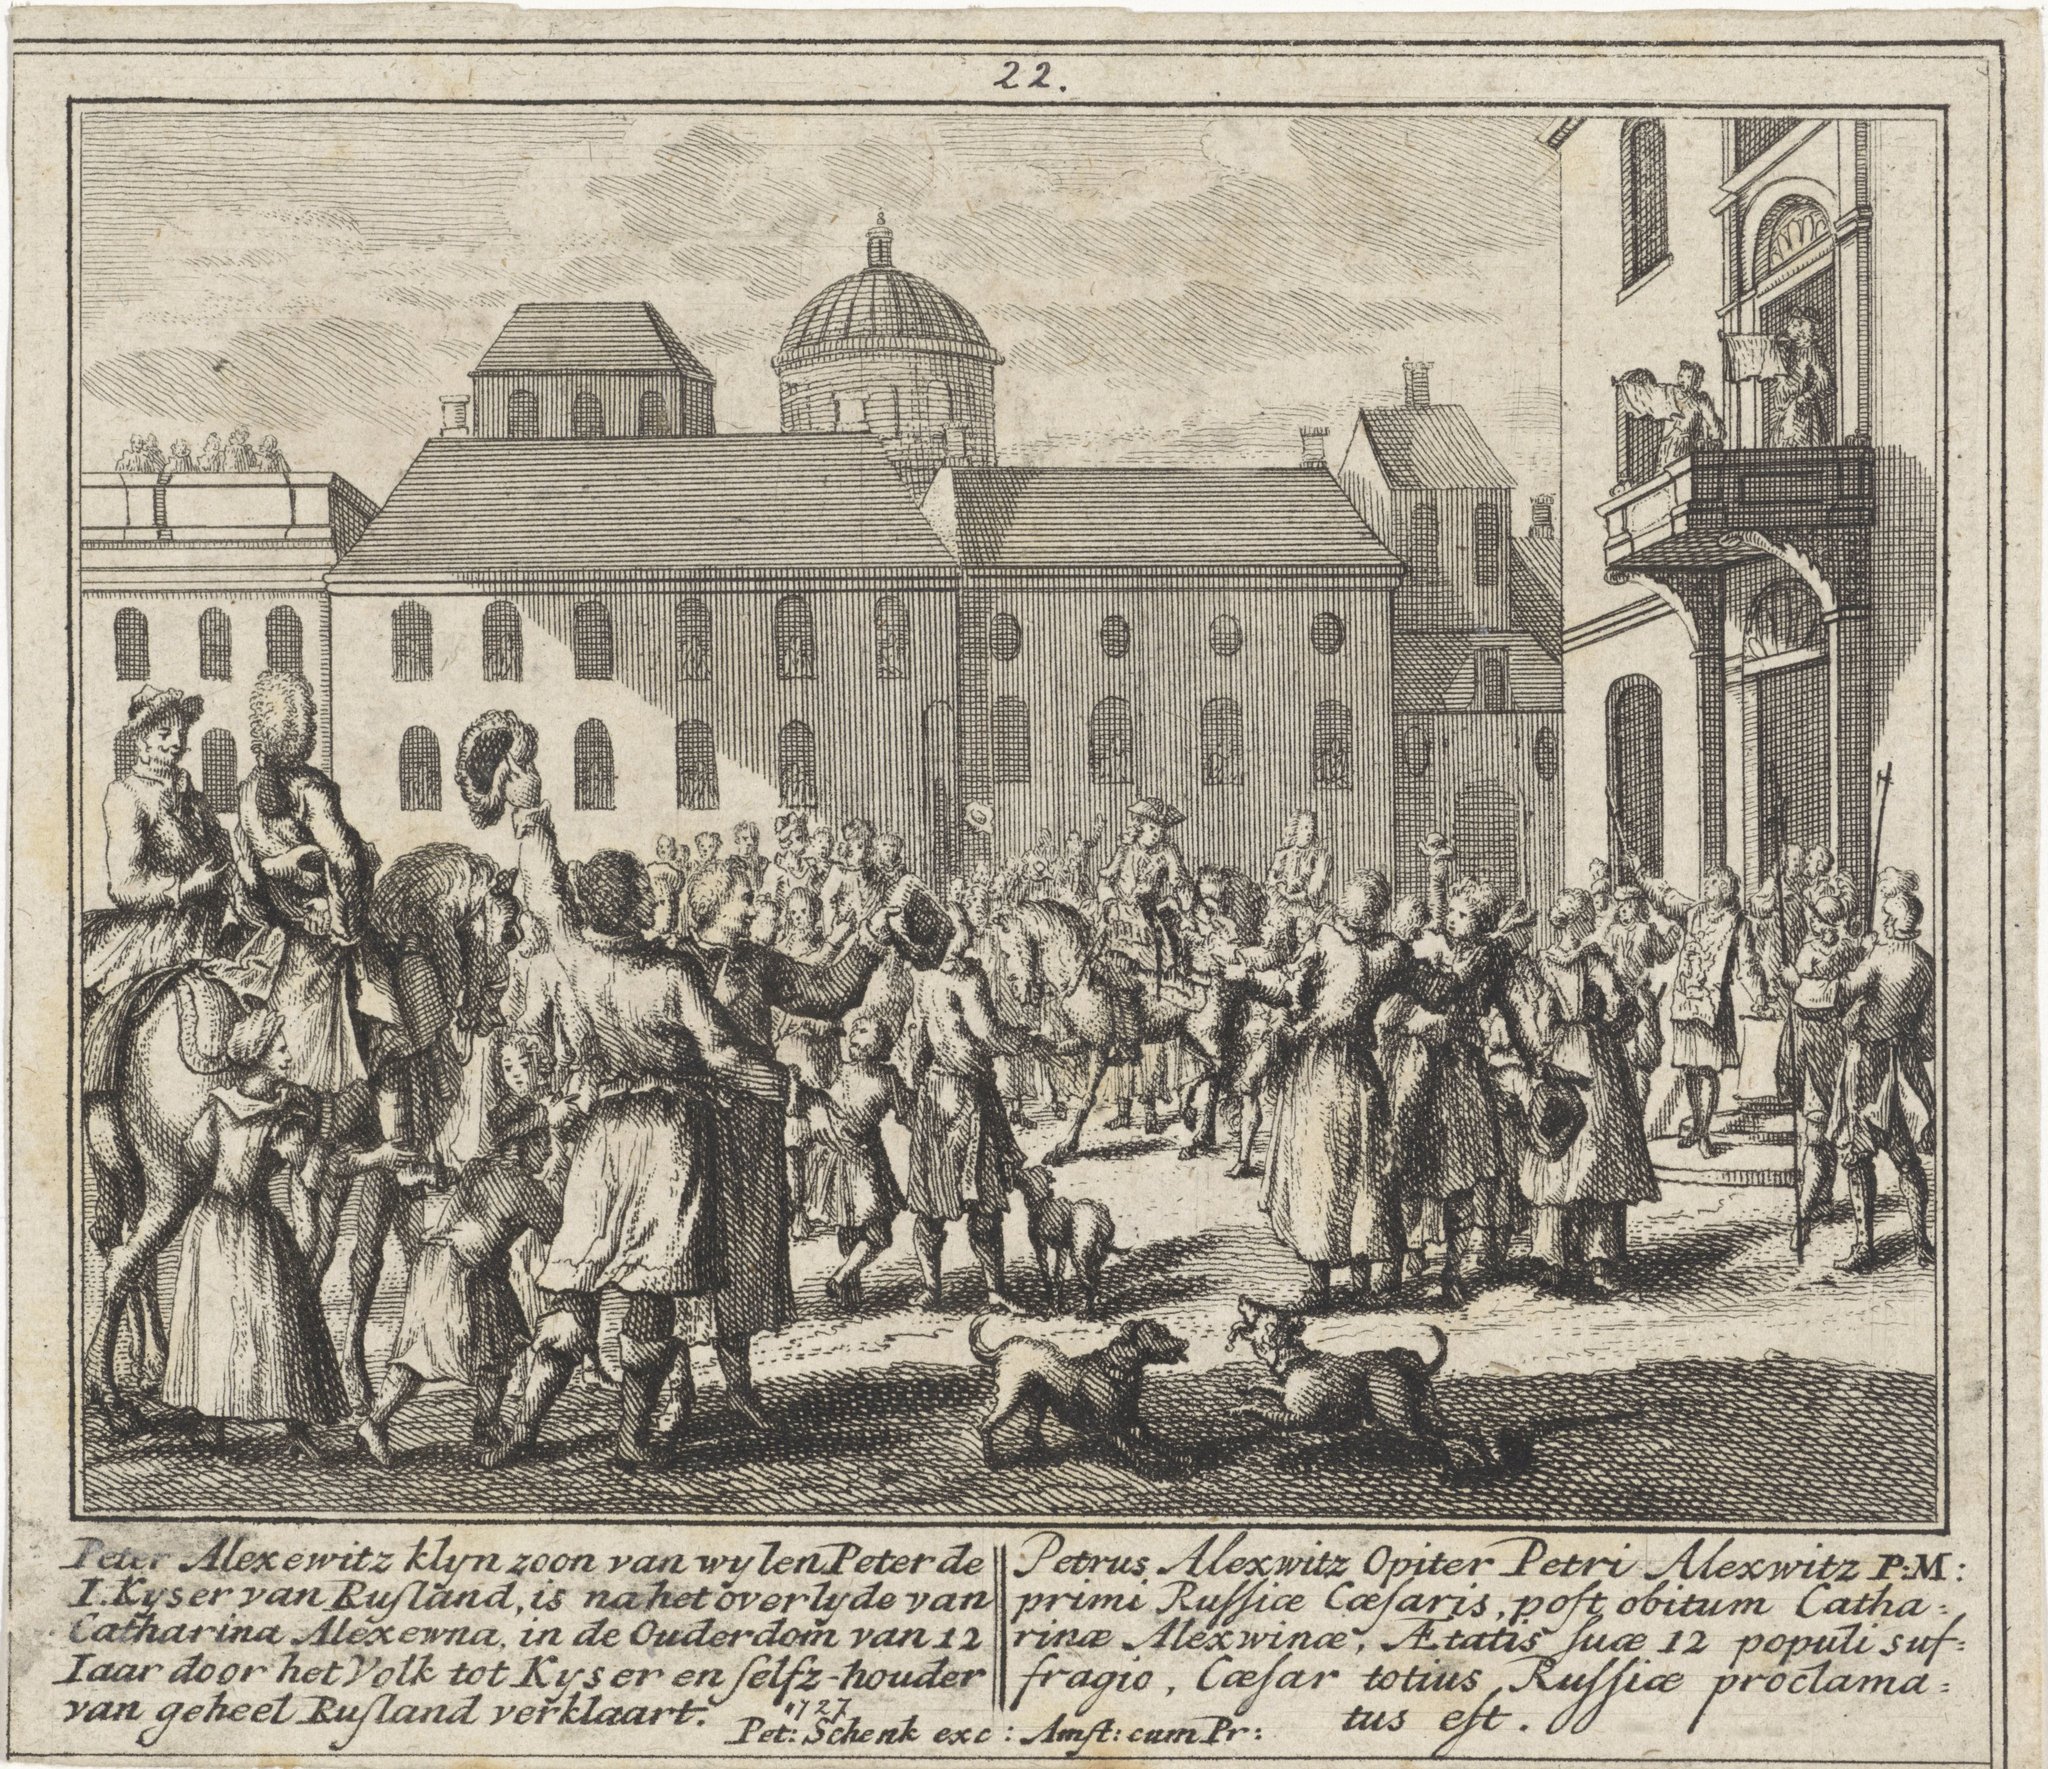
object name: print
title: Peter Alexewitz klyn zoon van wylen Peter de I Kyser van Rusland, is na het overlyde van Catharina Alexewna, in de Ouderdom van 12 Iaar door het Volk tot Kyser en selfz-houder van geheel Rusland verklaart, 1727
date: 1727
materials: paper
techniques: etching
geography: amsterdam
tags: proclamation of a ruler, square, place, circus, etc. (+ city(-scape) with figures, staffage)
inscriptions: collector's mark: Lugt 2228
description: Op een balkon van een gebouw aan een plein wordt Peter II Aleksejevitsj tot tsaar van Rusland uitgeroepen. Het volk op het plein juicht. Linksonder een vijfregelige tekst in het Nederlands met een toelichting op de voorstelling en rechts een vergelijkbare toelichting in het Latijn.